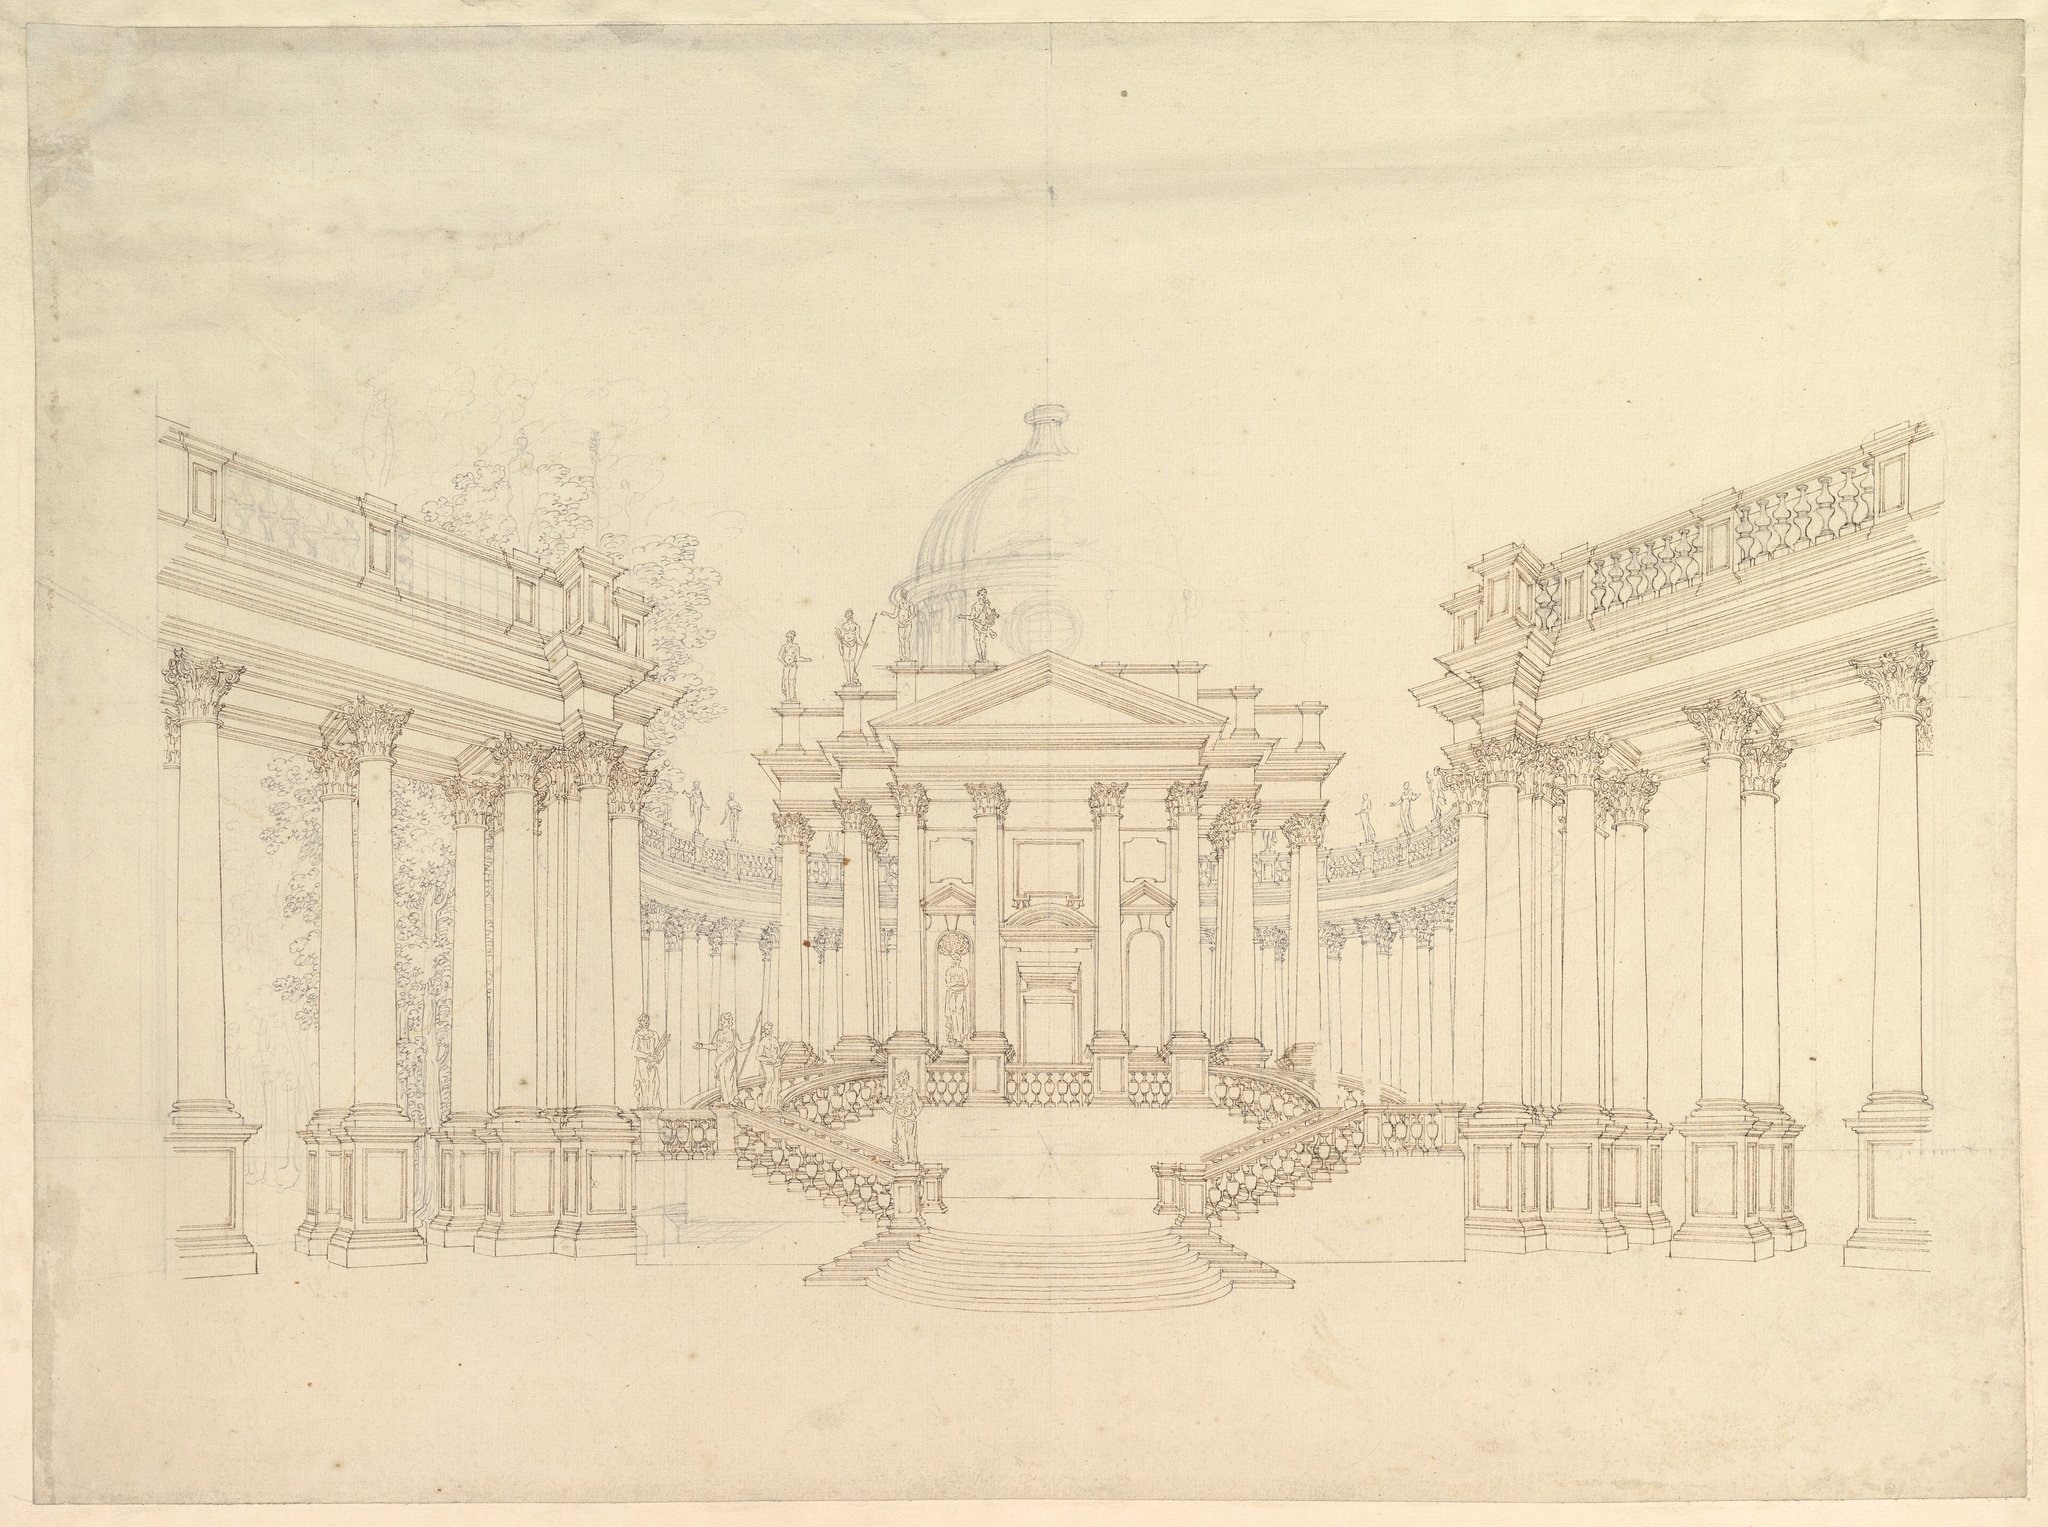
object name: drawing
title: Design for Stage Set: Centralized Villa with Cupola ("Villa rotunda" Style) and Colonnaded Wings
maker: giuseppe galli bibiena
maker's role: artist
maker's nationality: italian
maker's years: 1696-1756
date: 1696-1756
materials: chalk, ink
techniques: pen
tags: buildings,stage design